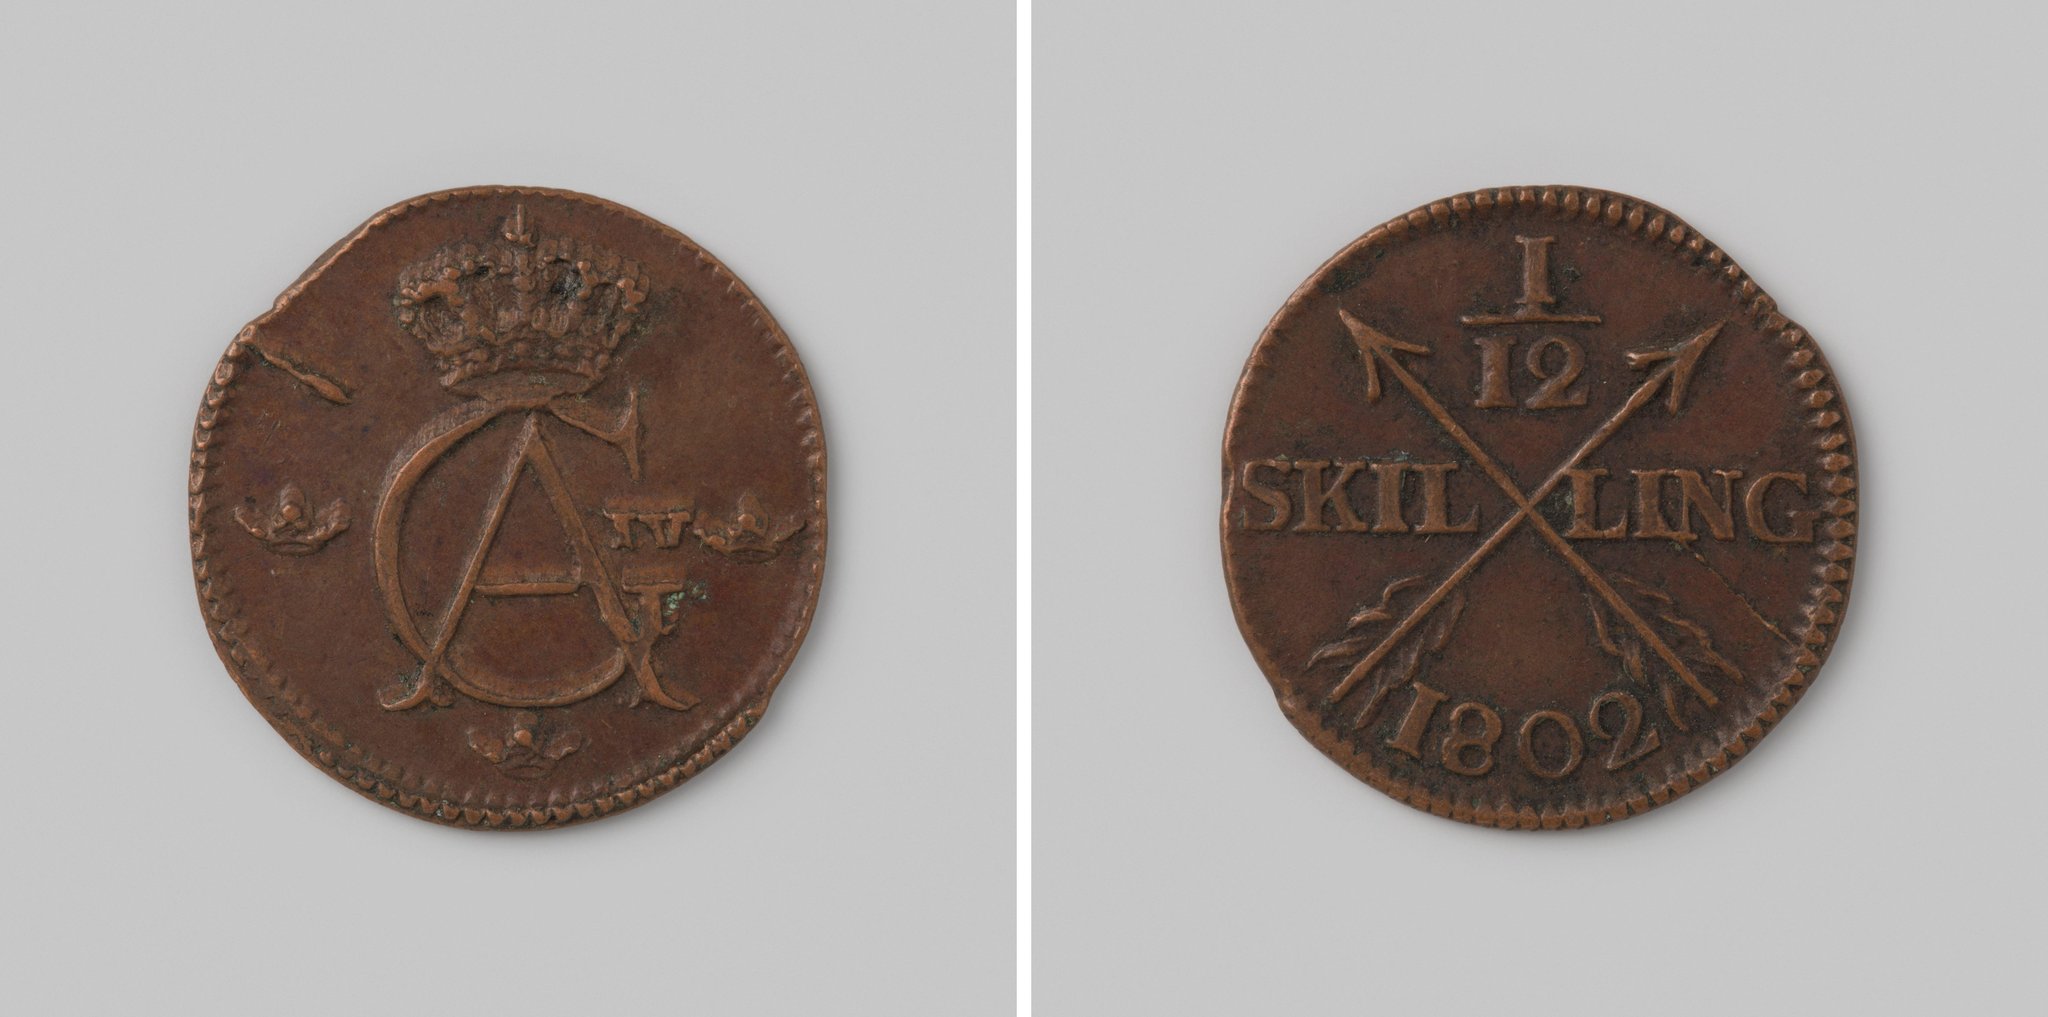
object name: coin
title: Zweden, Gustaf IV Adolf, 1/12 skilling, 1802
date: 1802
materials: copper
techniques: striking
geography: slot rörstrand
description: Koperen munt. Voorzijde: tussen drie kronen monogram van de vorst, waarboven koningskroon. Keerzijde: twee gekruiste pijlen. Waarde-aanduiding in het veld. Jaartal onderaan. Kartelrand.